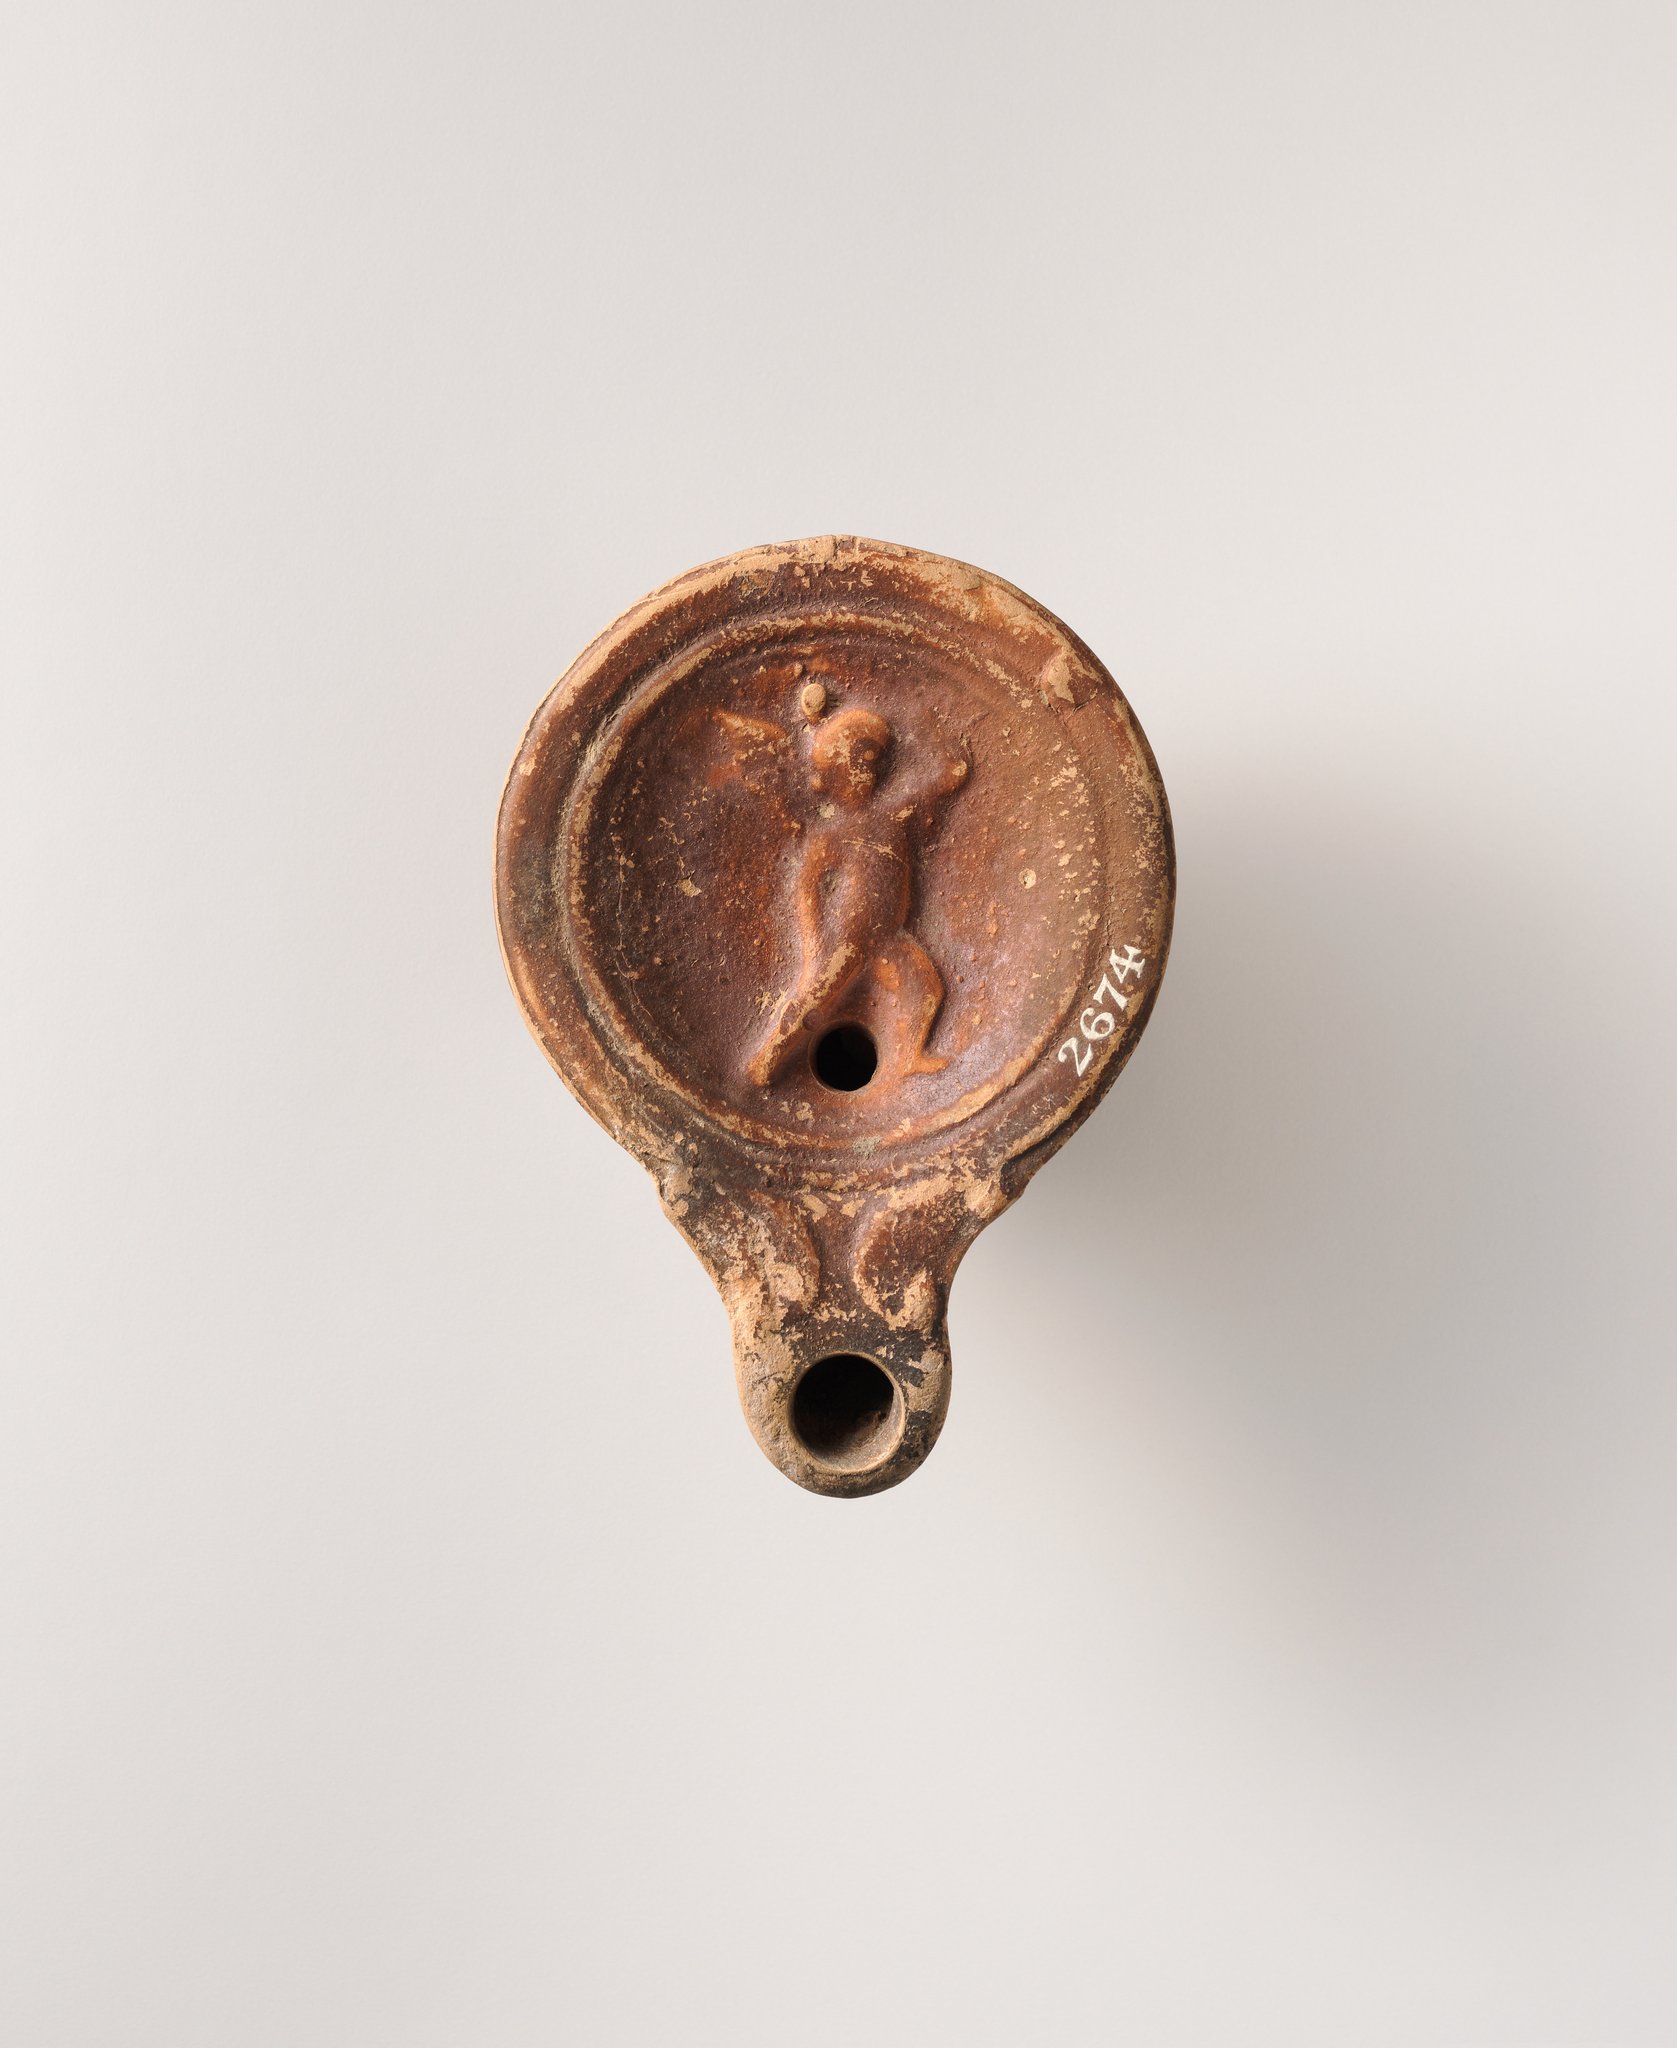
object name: lamp, concave top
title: Terracotta oil lamp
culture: roman, cypriot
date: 40-100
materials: terracotta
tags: eros